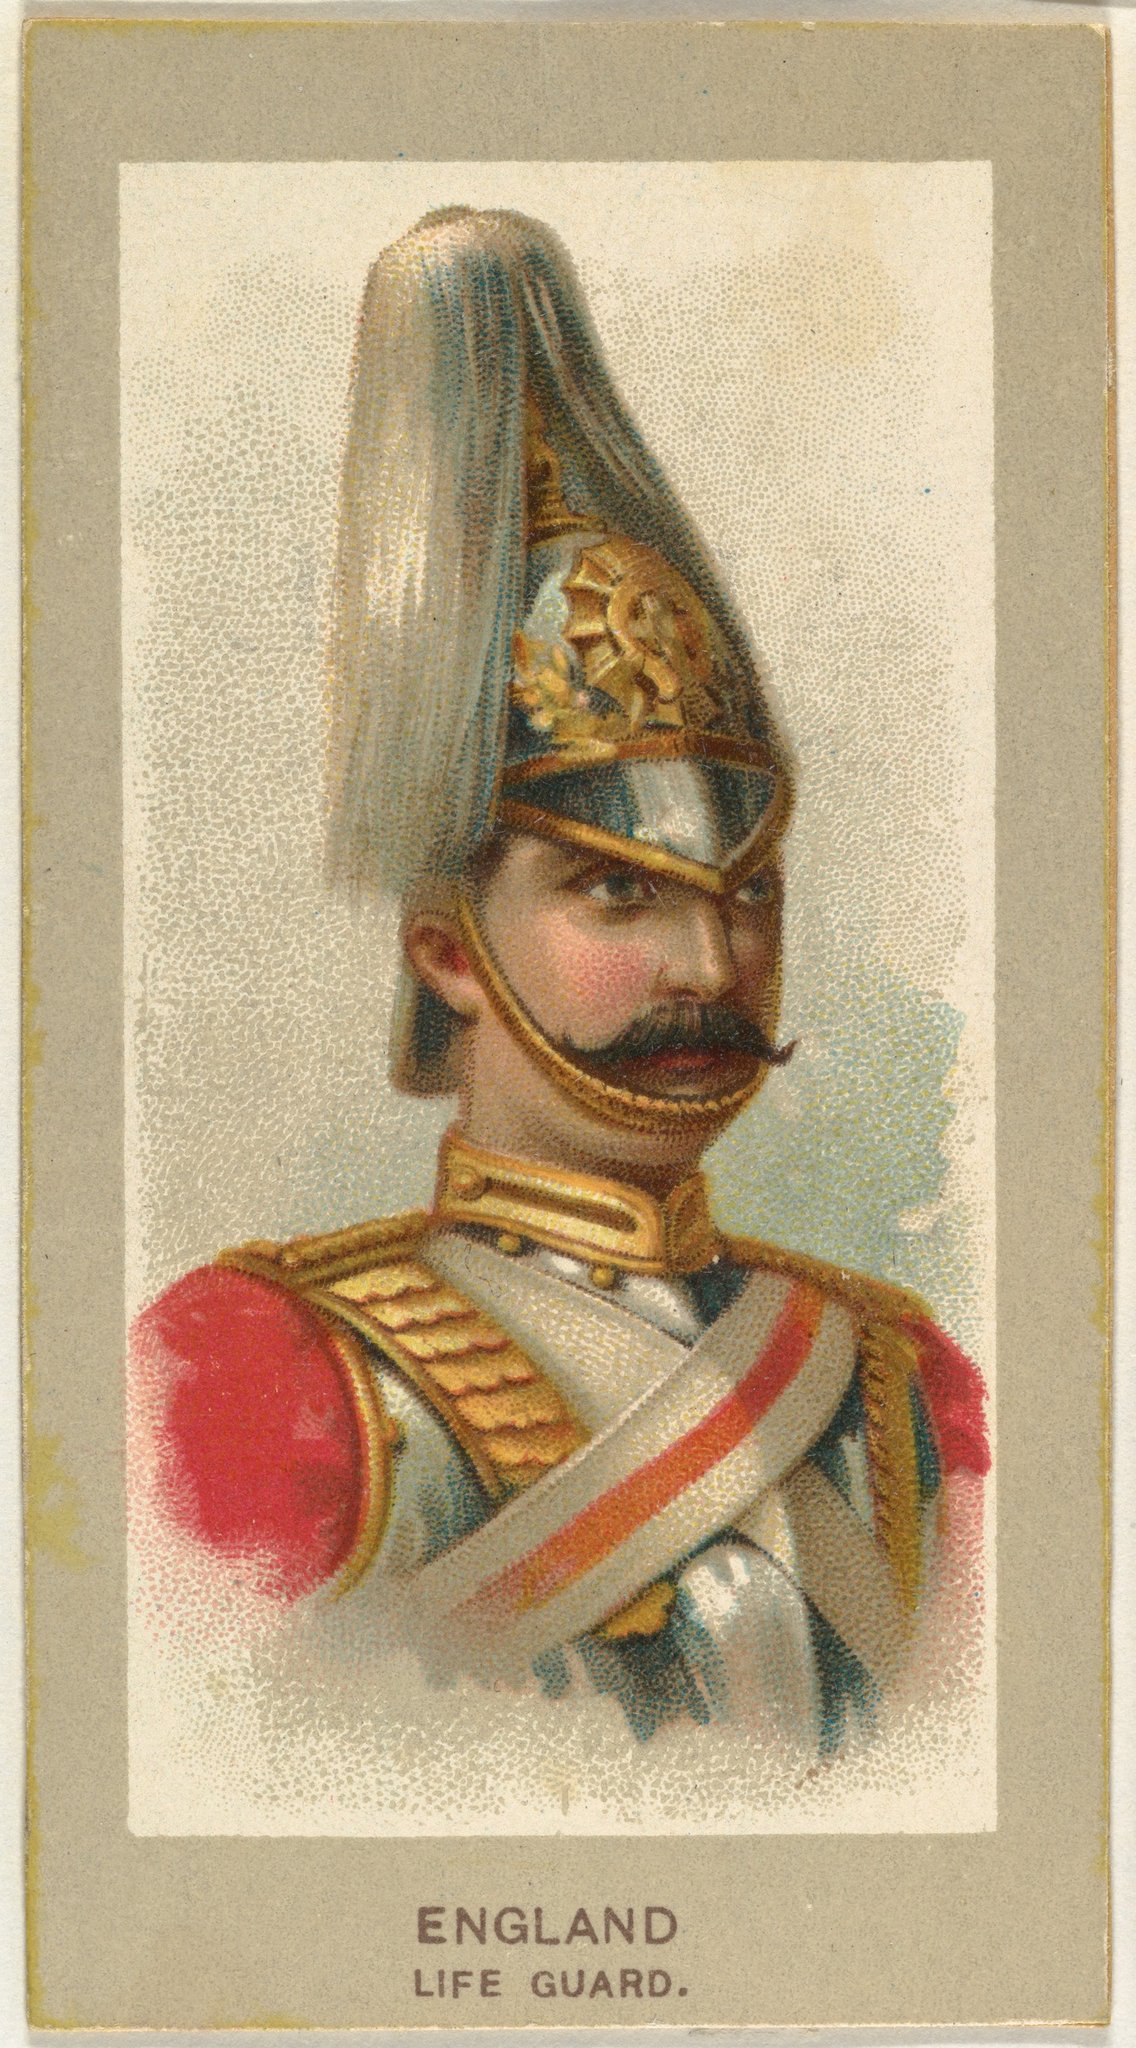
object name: print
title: Life Guard, England, from the Military Uniforms series (T182) issued by Abdul Cigarettes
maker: abdul cigarettes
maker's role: publisher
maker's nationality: american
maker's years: 1881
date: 1881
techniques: color lithograph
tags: uniforms,military,men